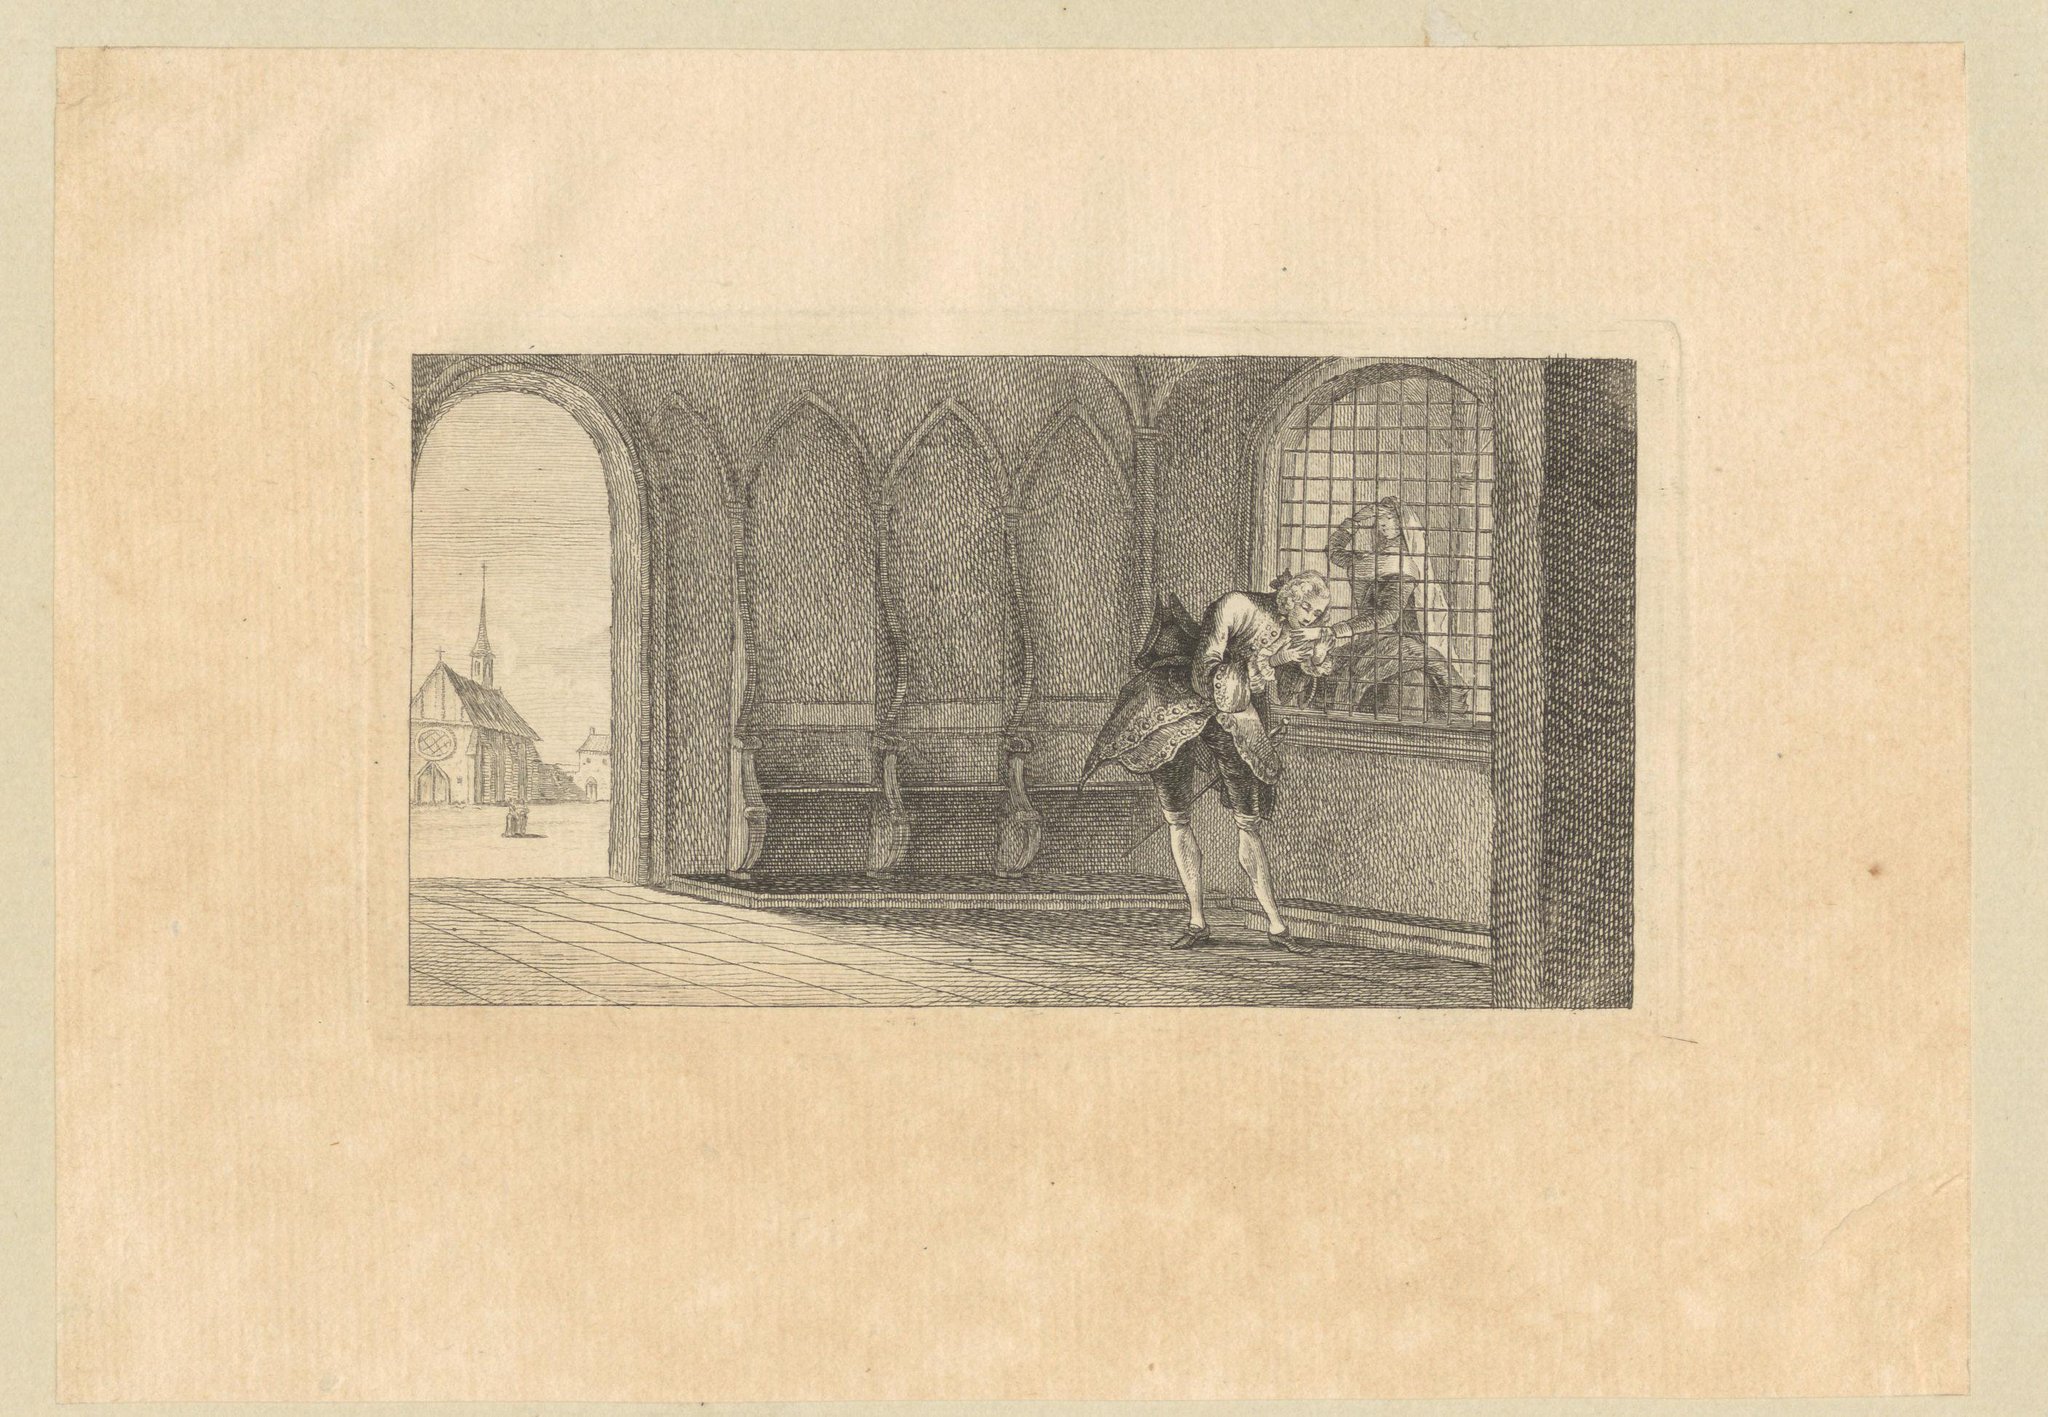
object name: book illustration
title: Geliefden in een vrouwenklooster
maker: georg friedrich schmidt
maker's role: draughtsman, print maker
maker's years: 1712-1775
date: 1774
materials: paper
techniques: etching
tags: cloisters ~ monastery, lovers' meeting, vignette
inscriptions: collector's mark: Lugt 240